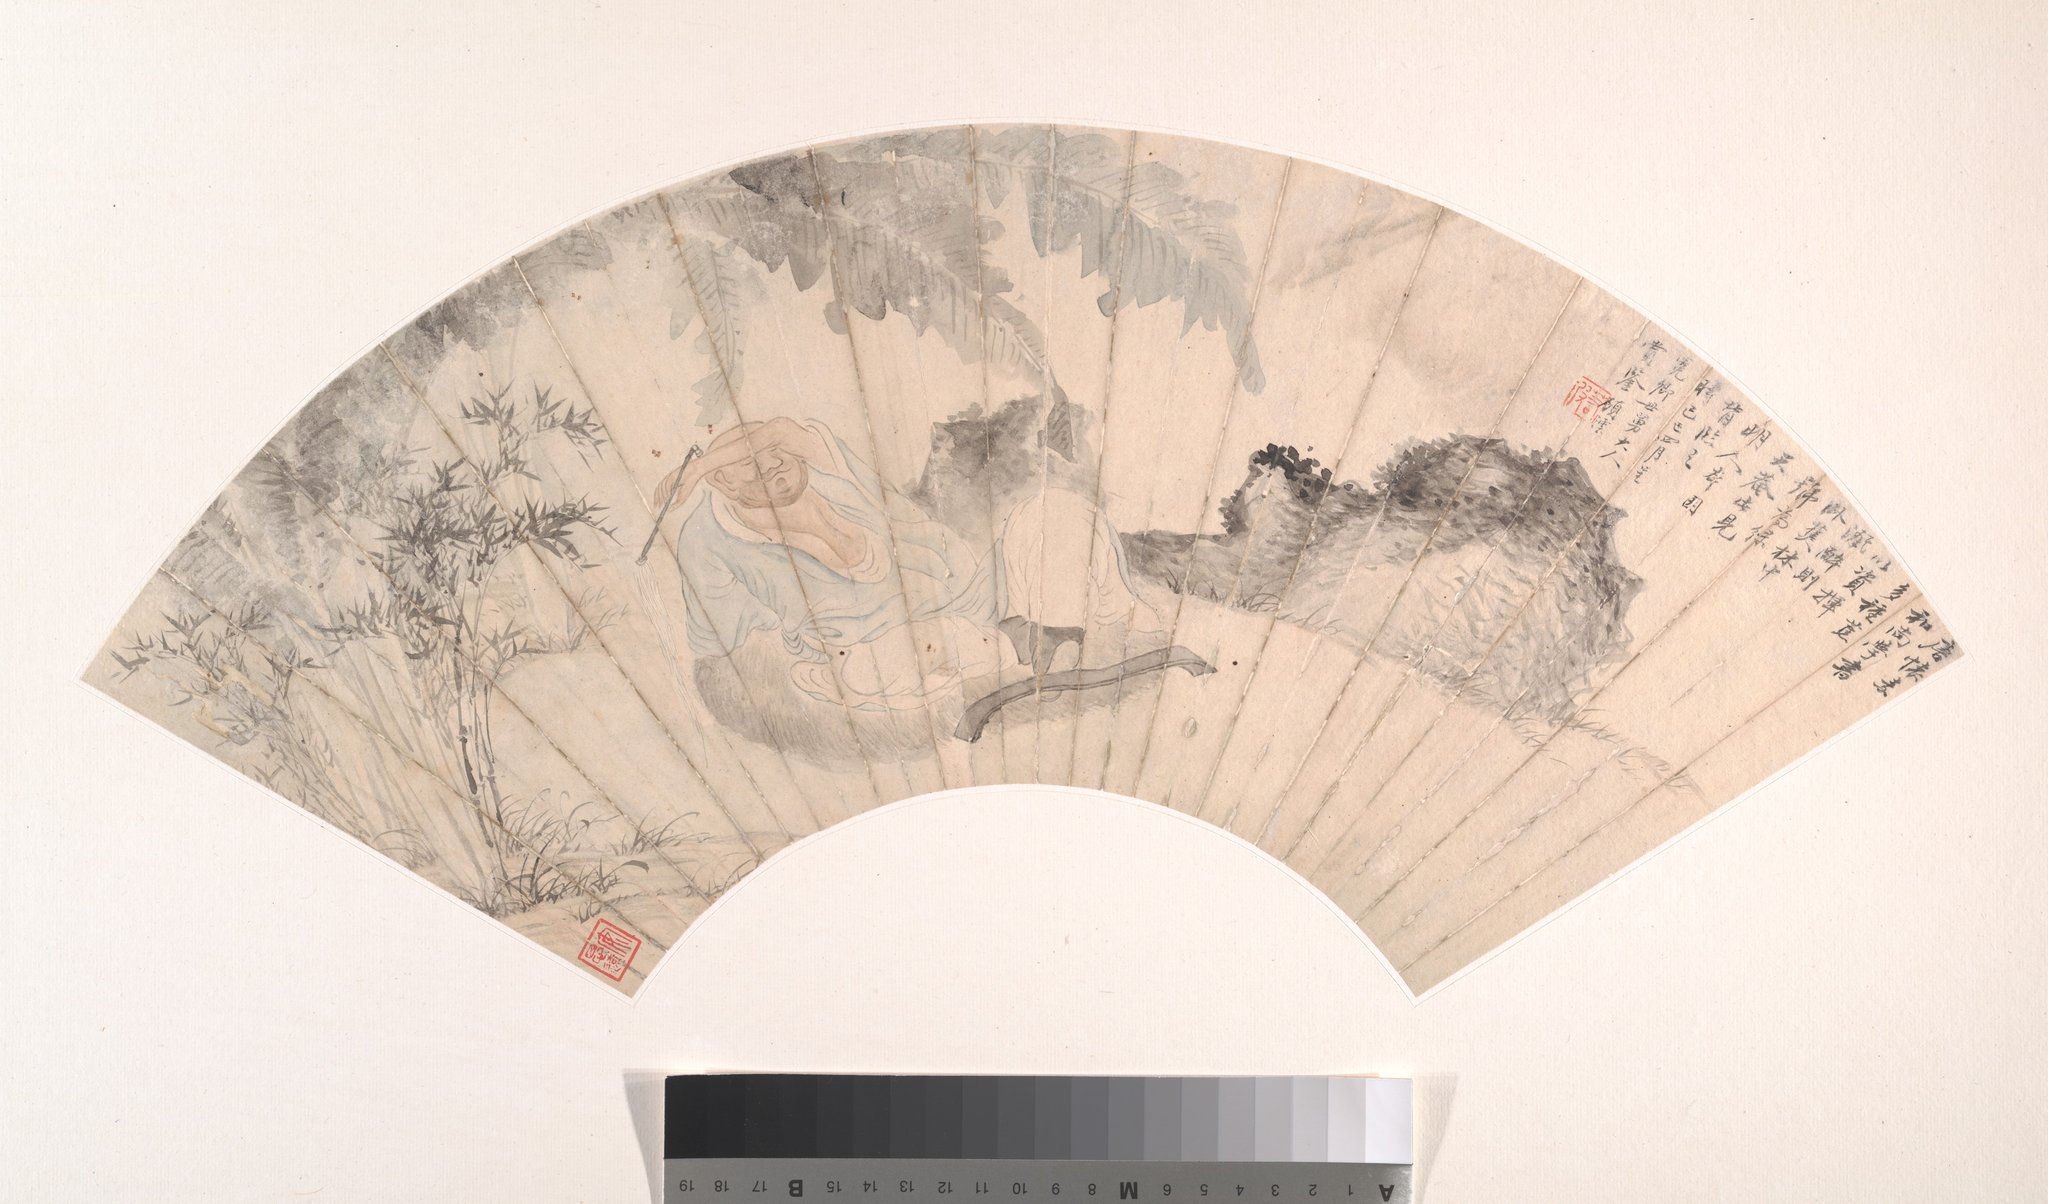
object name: folding fan mounted a an album leaf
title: Huaisu in the Banana Grove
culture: chinese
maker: gu yun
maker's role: artist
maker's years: 1835-1896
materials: ink, paper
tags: men